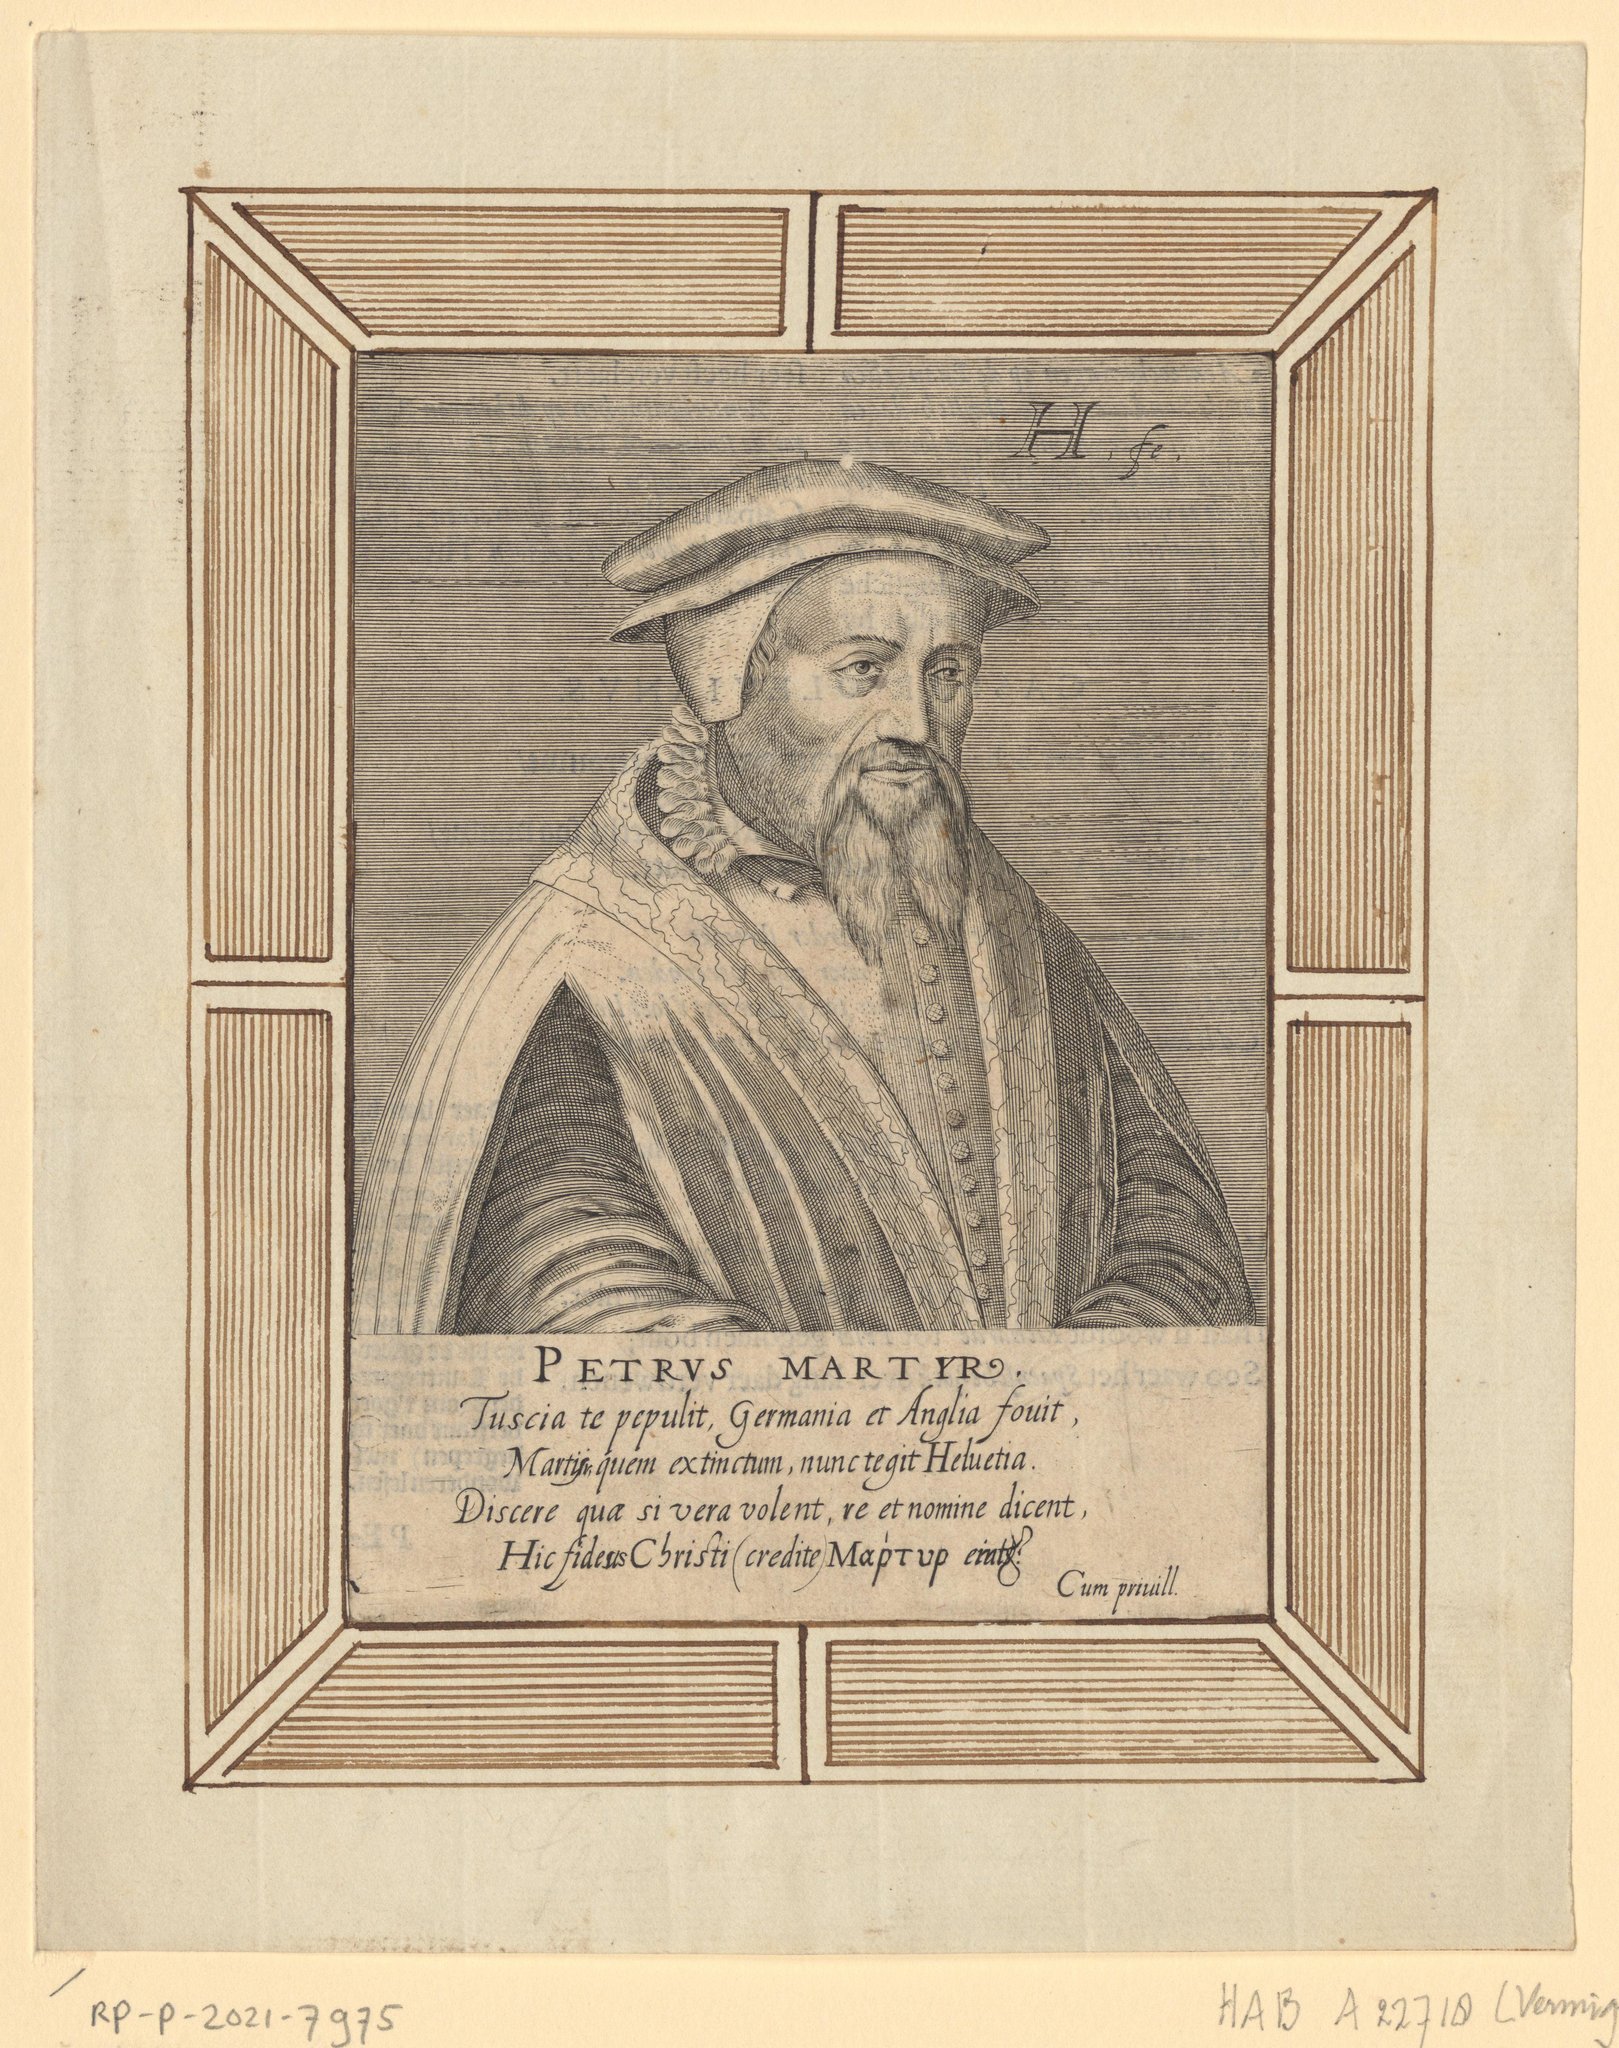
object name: print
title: Portret van Petrus Martyr Vermigli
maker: hendrick hondius (i)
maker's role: draughtsman, print maker, publisher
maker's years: 1573-1650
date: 1603-1604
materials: ink, paper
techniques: engraving, letterpress printing, pen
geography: the hague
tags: reformation (roman catholic church vs. protestantism), theologian, historical persons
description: Prent voor het eerst in 1599 gebruikt voor de serie: Icones virorum nostra patrumq. memoria illustrium. Prent uit: Verheiden, Jacob. Afbeeldingen van sommighe in Godts Woort ervarenen mannen (...). Den Haag: Beuckel Cornelisz Nieulandt, 1603. Of uit de druk uit 1604 uitgegeven door J. Janssen te Arnhem.